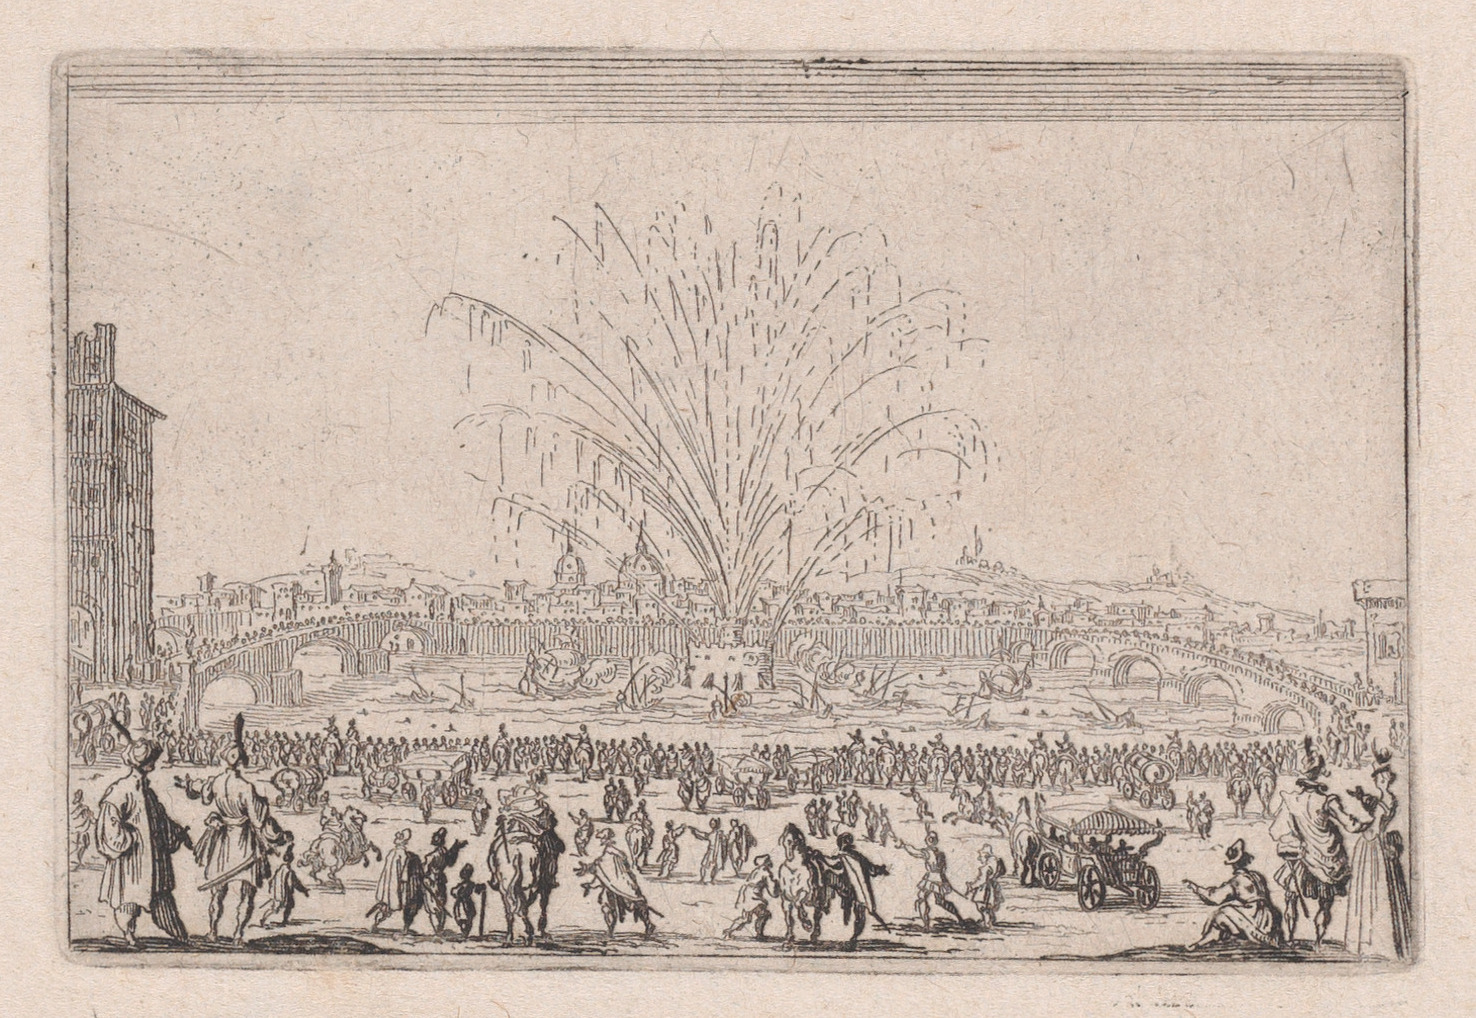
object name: print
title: Le Feu d'Artifice sur l'Arno (Fireworks on the Arno), from "Les Caprices" Series B, The Nancy Set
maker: jacques callot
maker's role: artist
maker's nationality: french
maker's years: 1592-1635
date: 1617-1620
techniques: etching